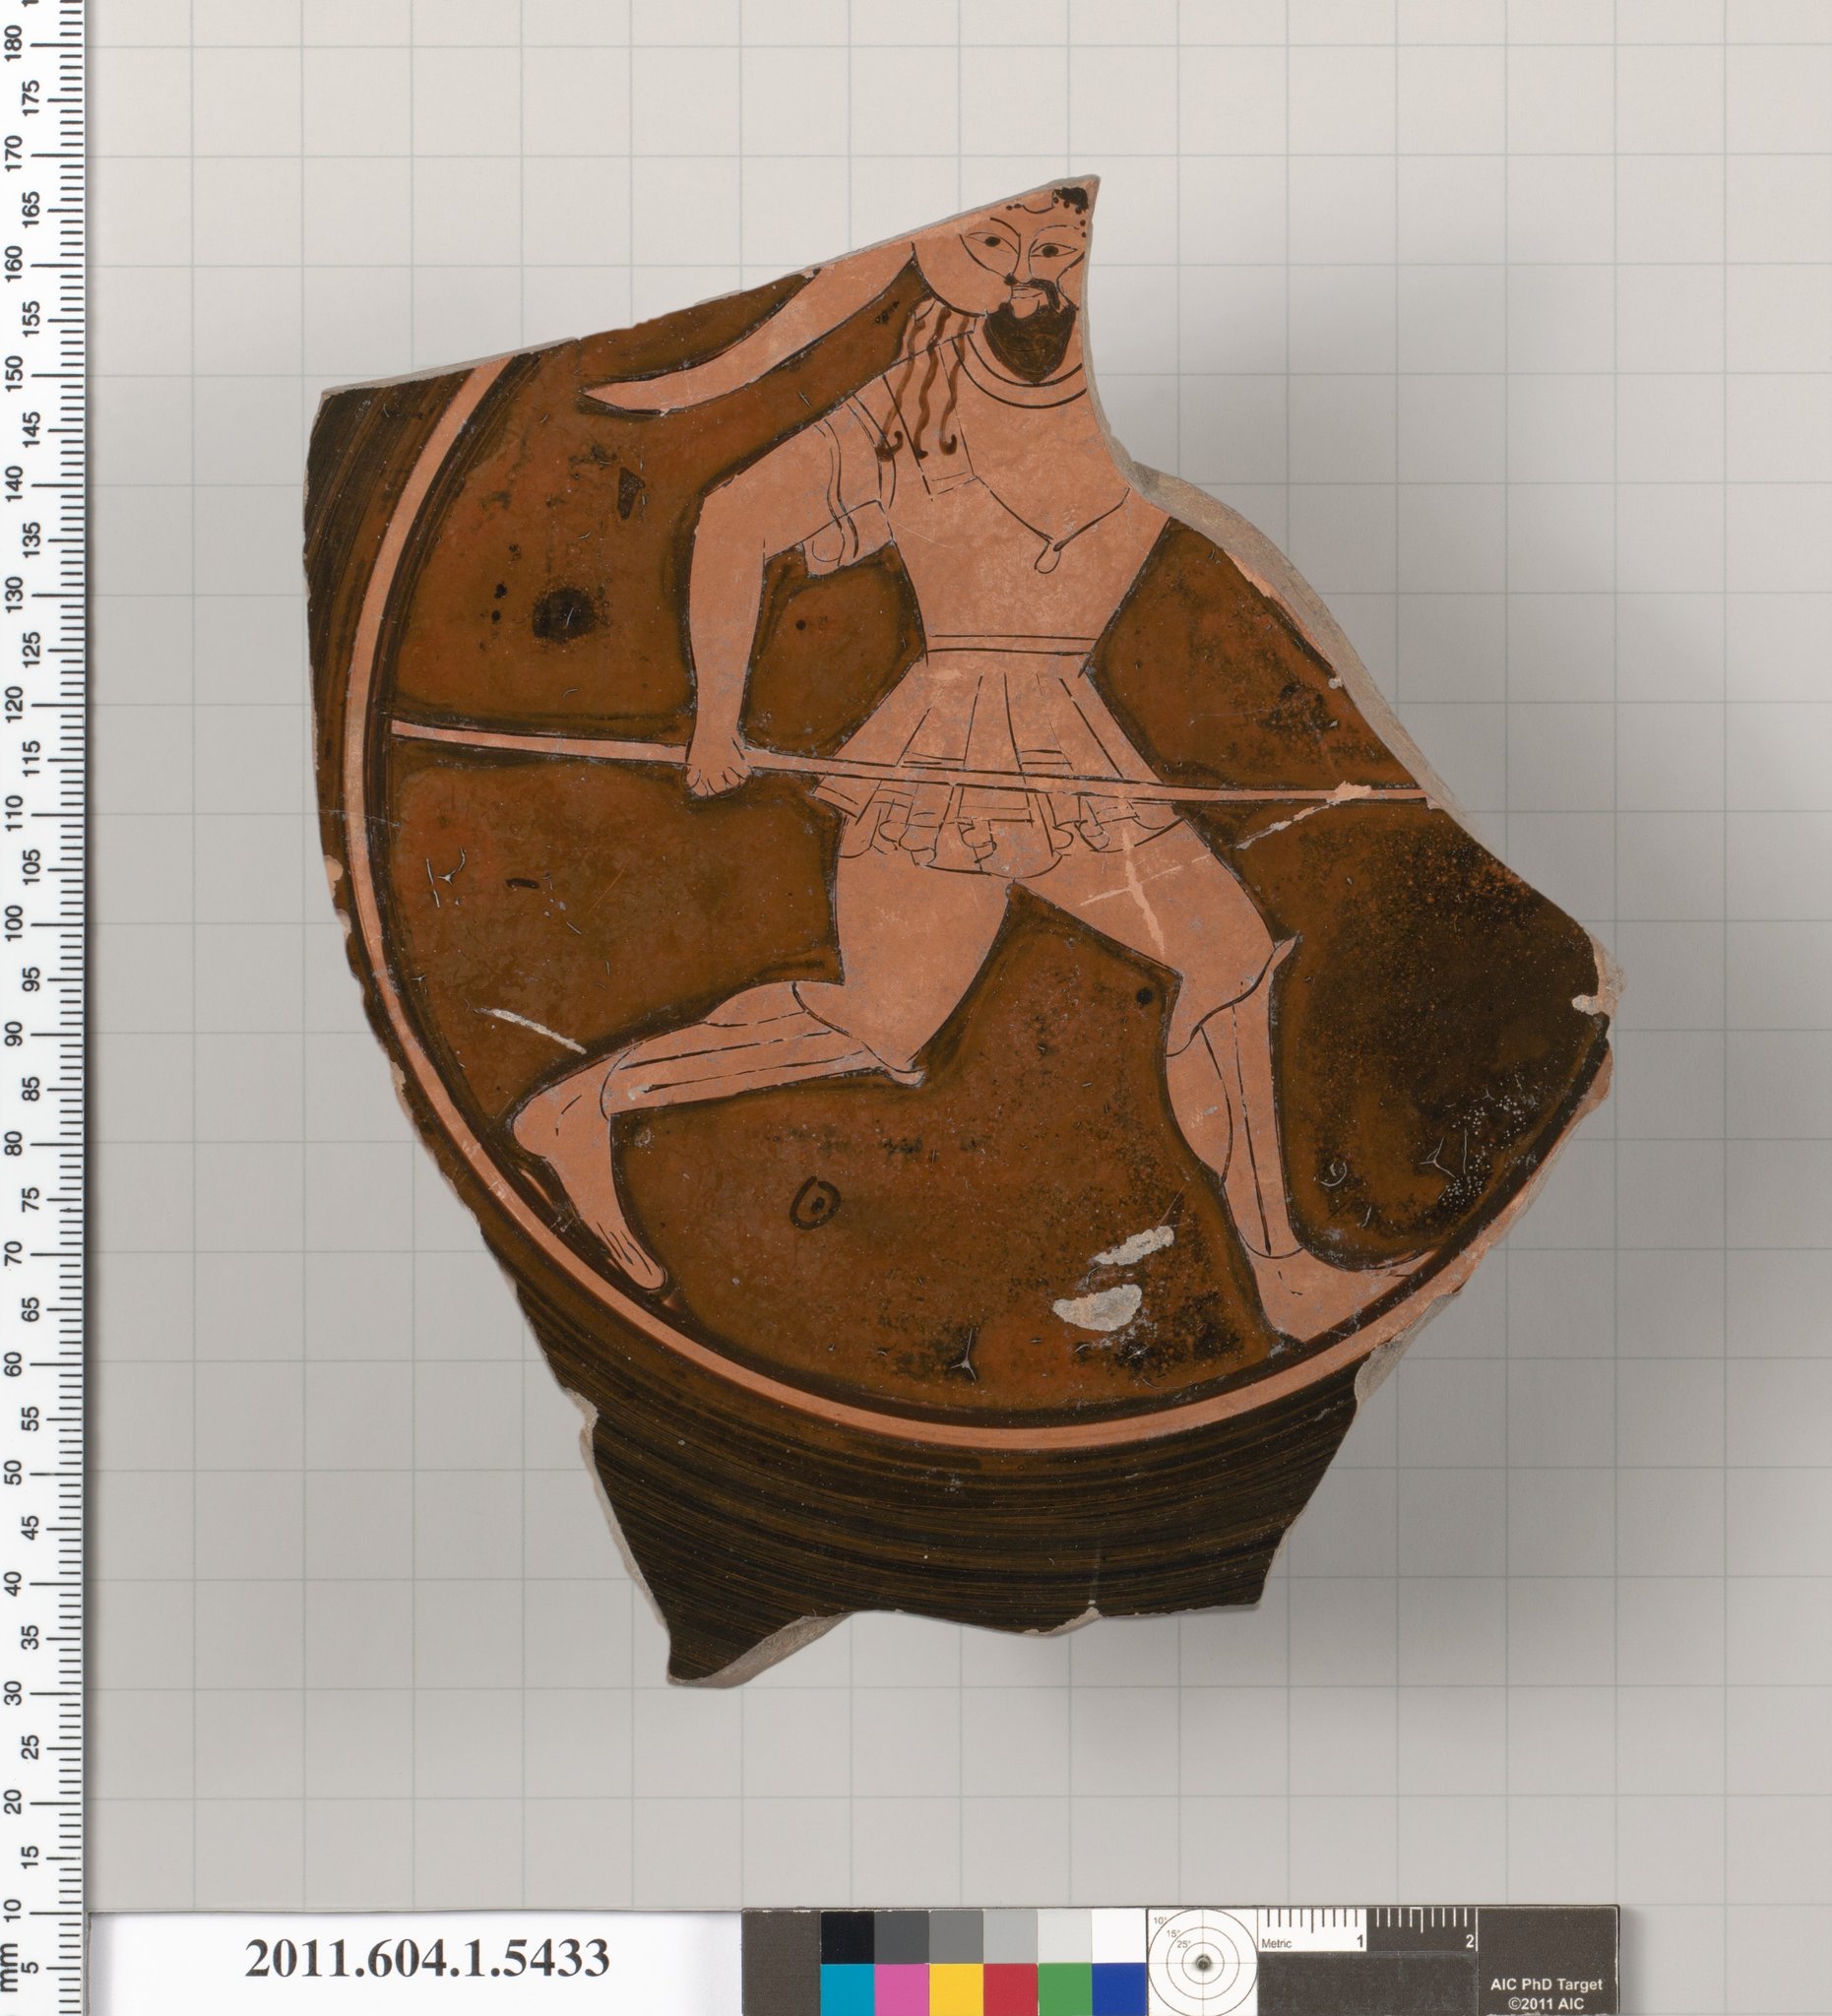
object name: kylix fragment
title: Terracotta fragment of a kylix (drinking cup)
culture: greek, attic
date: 475-451 BCE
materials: terracotta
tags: spears,men,warriors